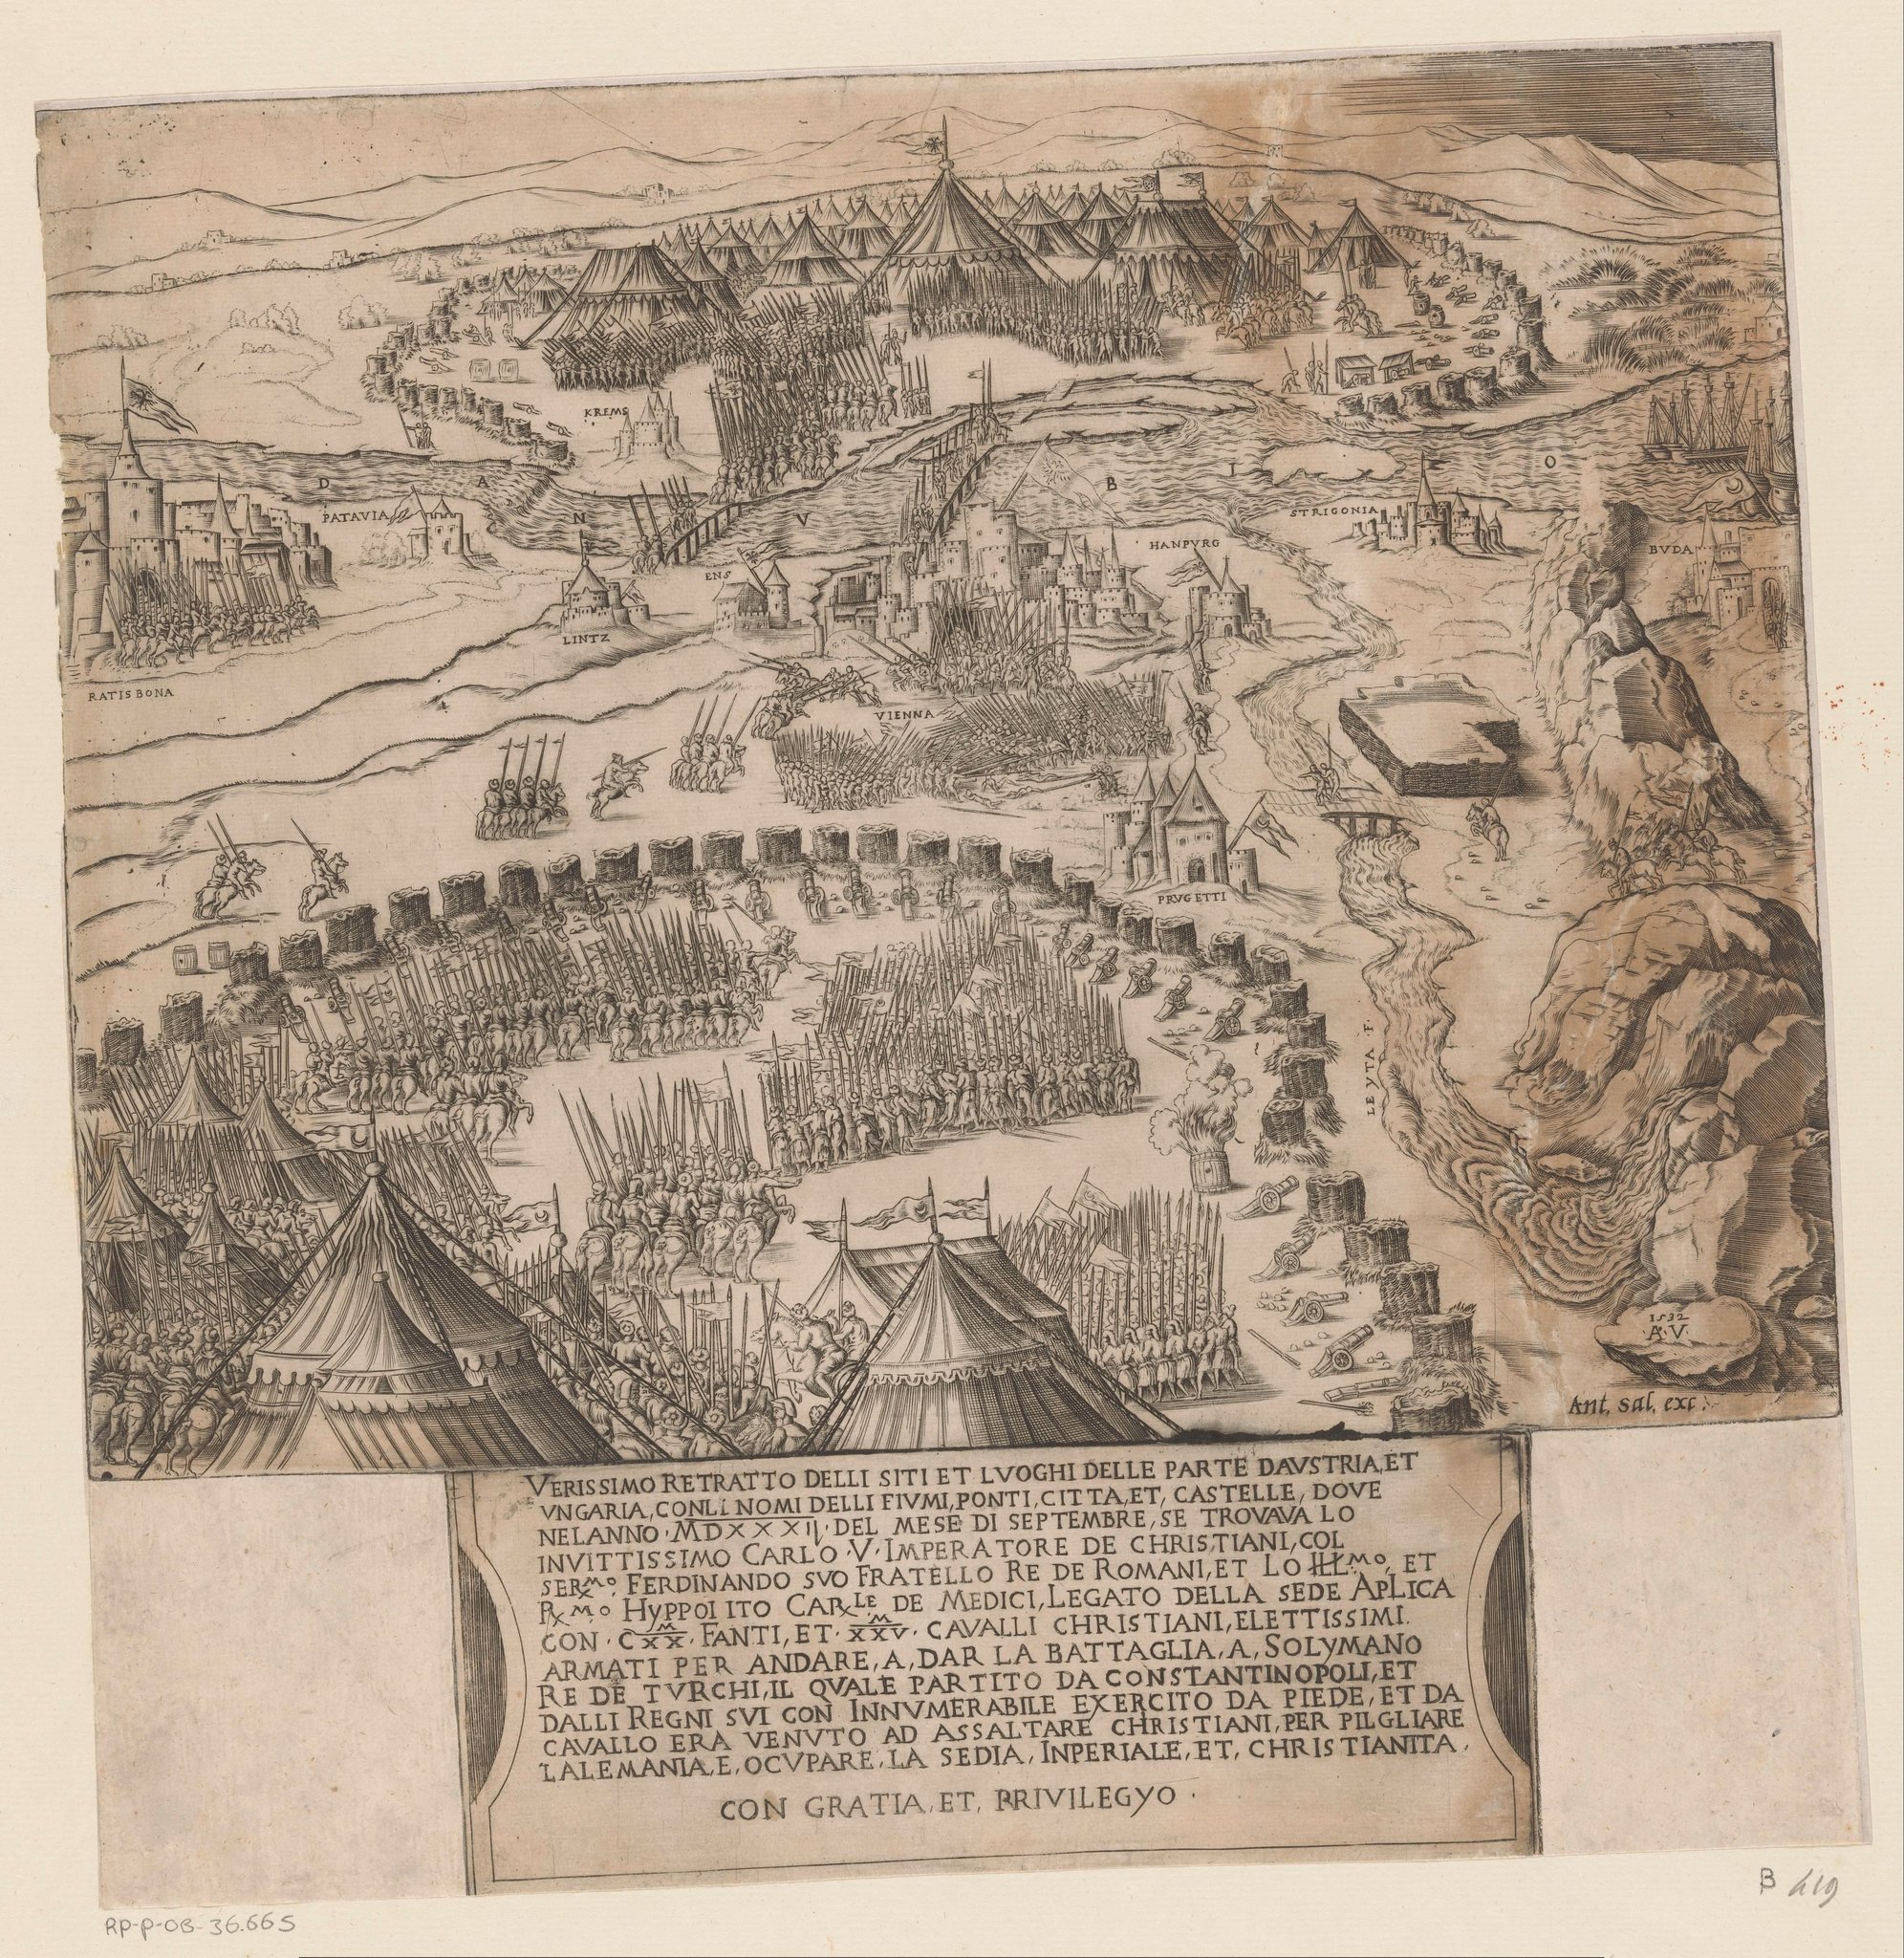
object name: print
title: Belegering van Wenen door de Ottomanen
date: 1532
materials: paper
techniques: engraving, etching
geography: italy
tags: ghent, charles v (holy roman emperor and king of spain), battle, warfare; military affairs (+ cavalry, horsemen), the soldier; the soldier's life, siege, vienna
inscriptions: collector's mark: Lugt 12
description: Gezicht in vogelvlucht op het slagveld rondom Wenen. Op de voorgrond het Ottomaanse leger onder leiding van sultan Süleyman I, dat in september 1532 voor de tweede keer Wenen belegerde. Aan de andere kant van de Donau is het Habsburgse leger onder leiding van keizer Karel V gepositioneerd. Op het middenplan wordt de strijd om Wenen voltrokken. Verscheidene omliggende geografische locaties zijn op de prent afgebeeld. Midden onder een cartouche met een twaalfregelige tekst in het Latijn.